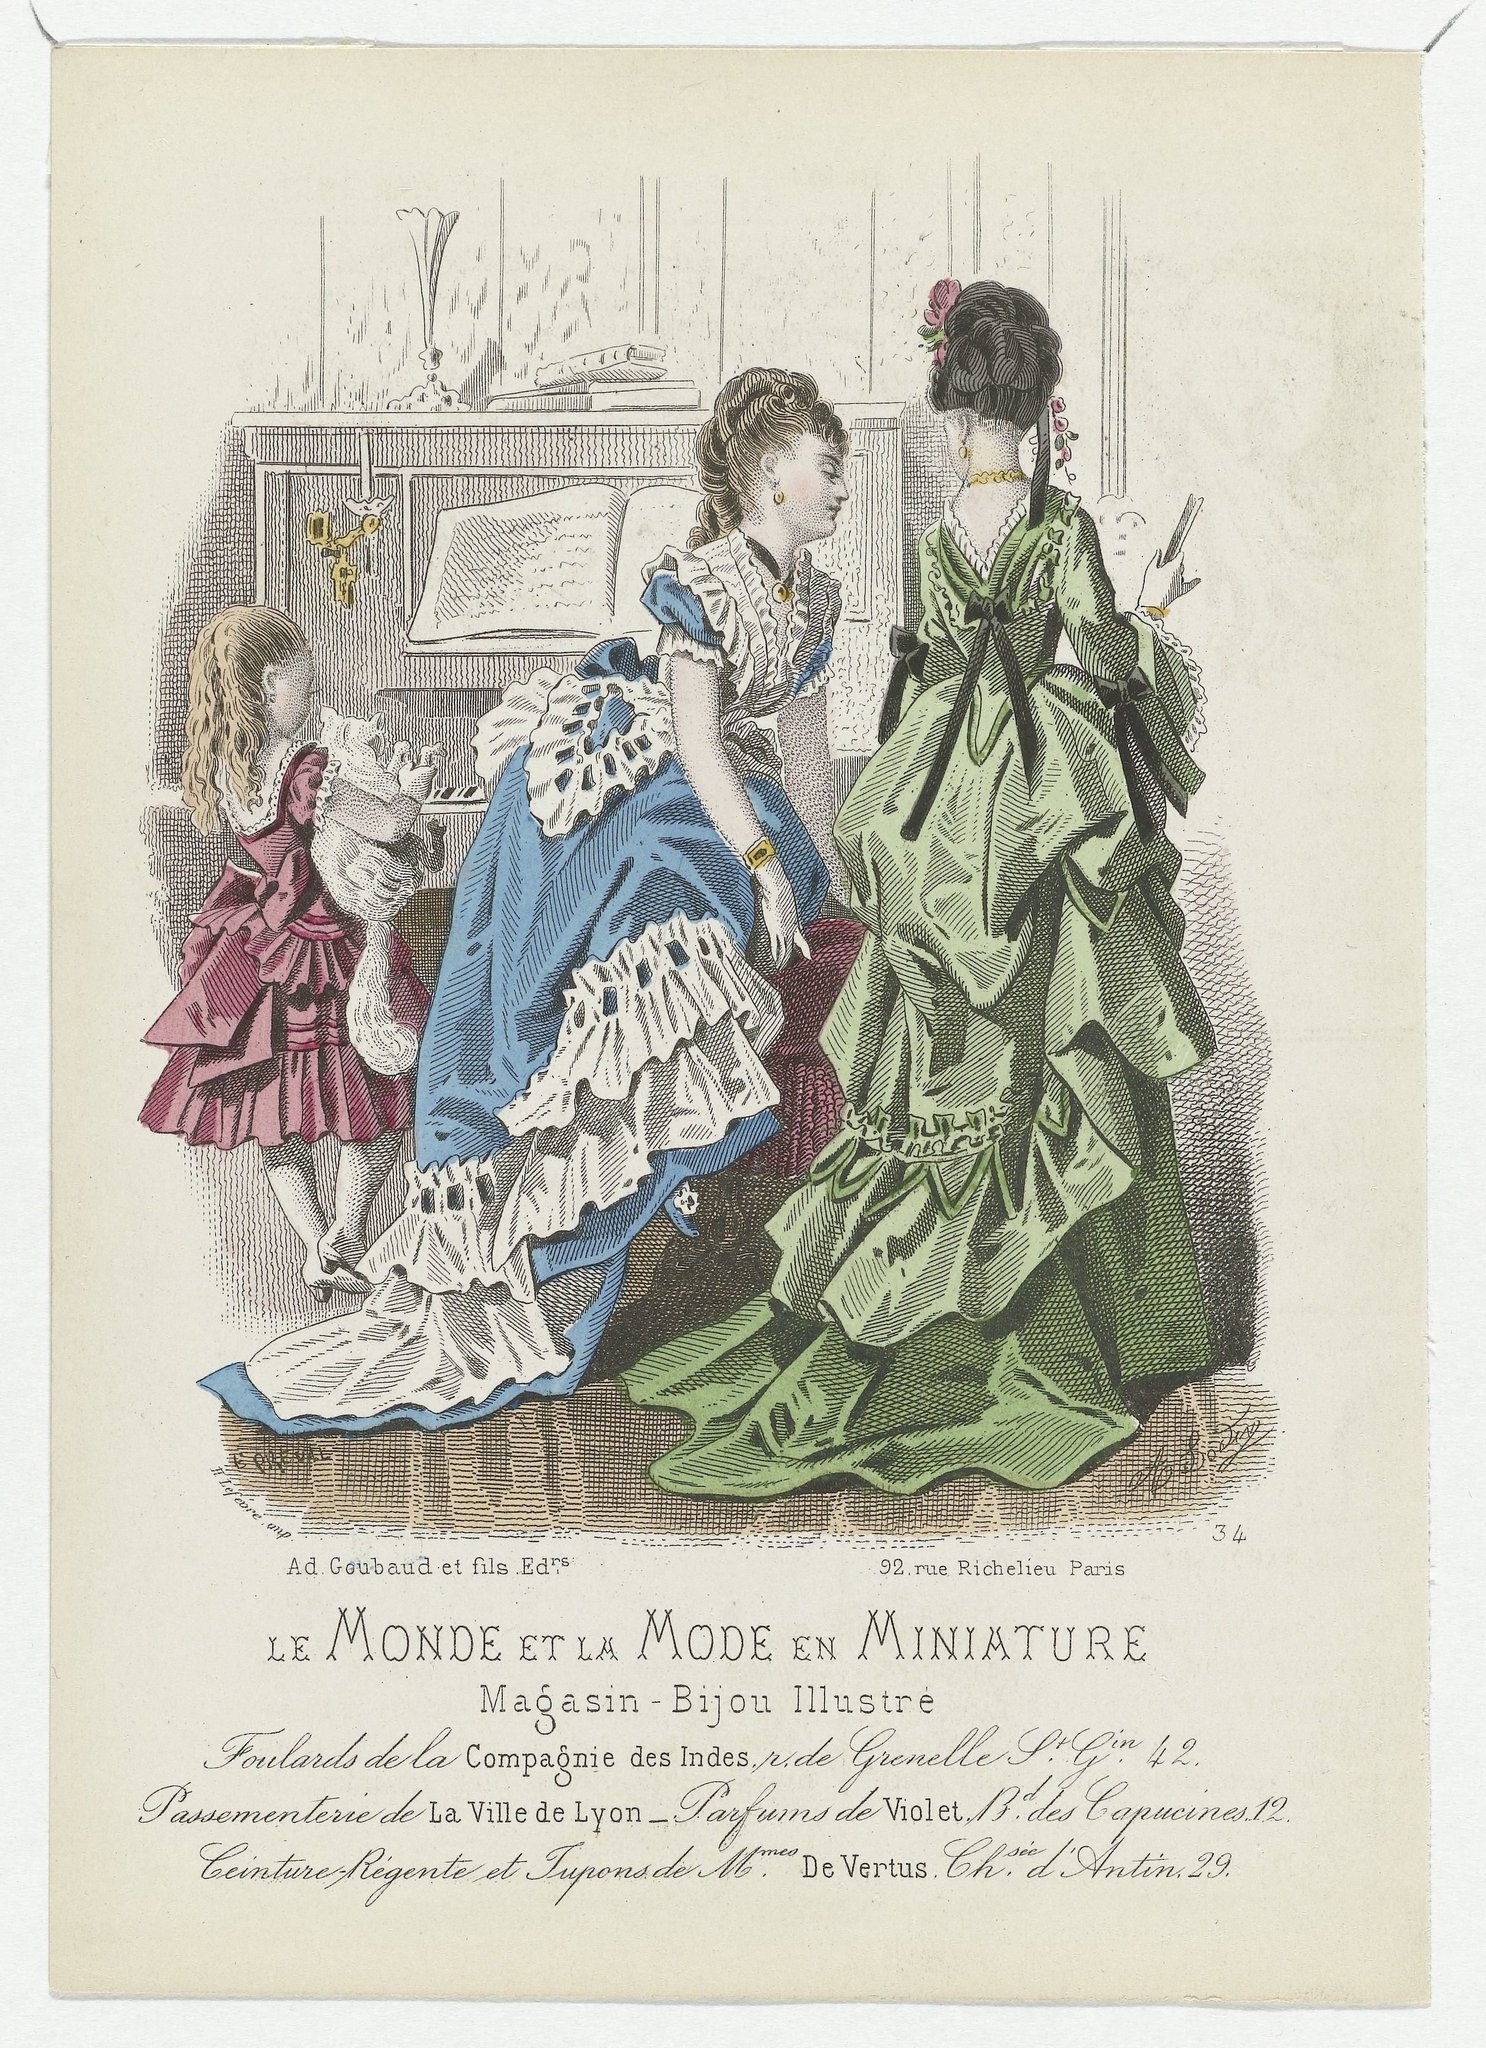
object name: fashion print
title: Le Monde et la Mode en Miniature, 1873, No. 34 : Foulards de la Compagni (...)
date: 1873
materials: paper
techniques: engraving, hand coloring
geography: paris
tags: cat, fashion plates, dress, gown (+ women's clothes), bracelet, wristlet (+ women's clothes), necklace (+ women's clothes), pianoforte, dress, gown (+ girls' clothes)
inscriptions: caption: ‘Foulards de la Compagnie des Indes r. de Grenelle St Gin 42. Passementerie de La Ville de Lyon _ Parfums de Violet Bd des Capucines 12 Ceinture-Régente et Jupons de Mmes De Vertus Chsée d'Antin 29’, title: ‘Le Monde et la Mode en Miniature / Magasin - Bijou Illustré’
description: Twee vrouwen en een kind in interieur, gekleed in japonnen met tournure, gemaakt uit stoffen van Compagnie des Indes met passement van Ville de Lyon. Prent uit het modetijdschrift Le Monde et la Mode en Miniature (1873-1874). De prent is waarschijnlijk een verkleinde kopie naar No. 1073b van het modetijdschrift Le Journal des Dames et des Demoiselles, 1973.